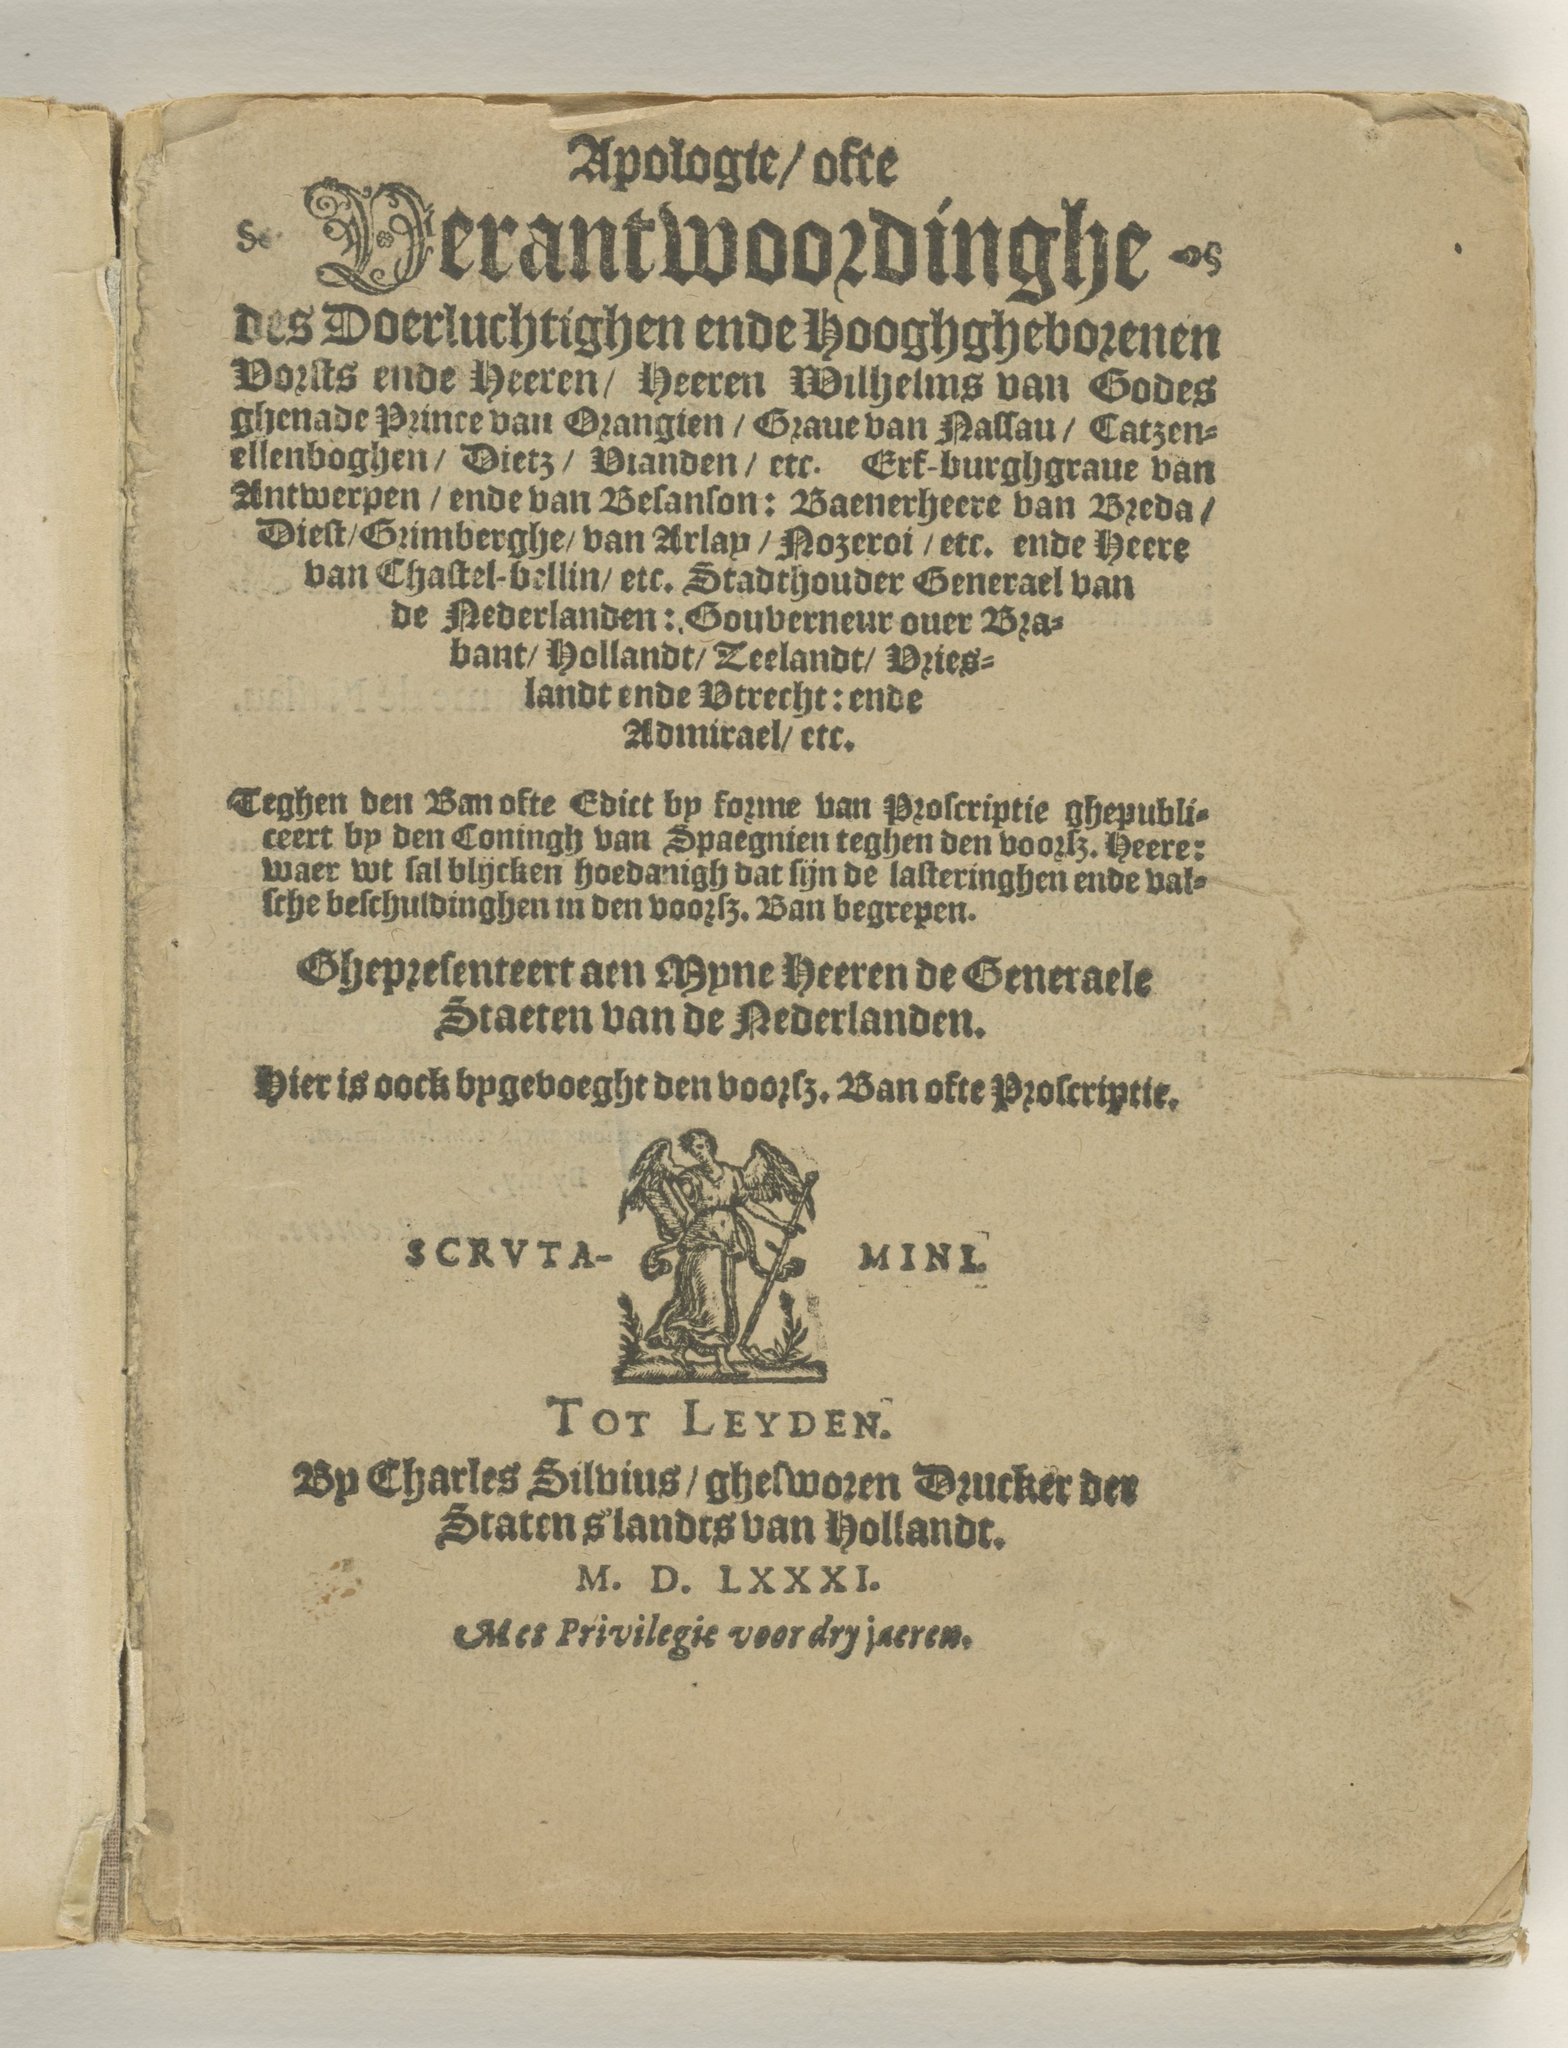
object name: book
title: Apologie ofte verantwoording des Doerluchtigen ende Hooghgheborenen Vorsts en Heeren, Heeren Wilhelms (...) Prince van Orangien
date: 1581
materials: cardboard, paper, textile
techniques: bookbinding, printing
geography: leiden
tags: philip ii of spain, delft, william i (prince of orange)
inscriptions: date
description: Pamflet waarin Willem van Oranje zich verdedigde tegen de banvloek die Filips II een jaar eerder over hem had uitgesproken.